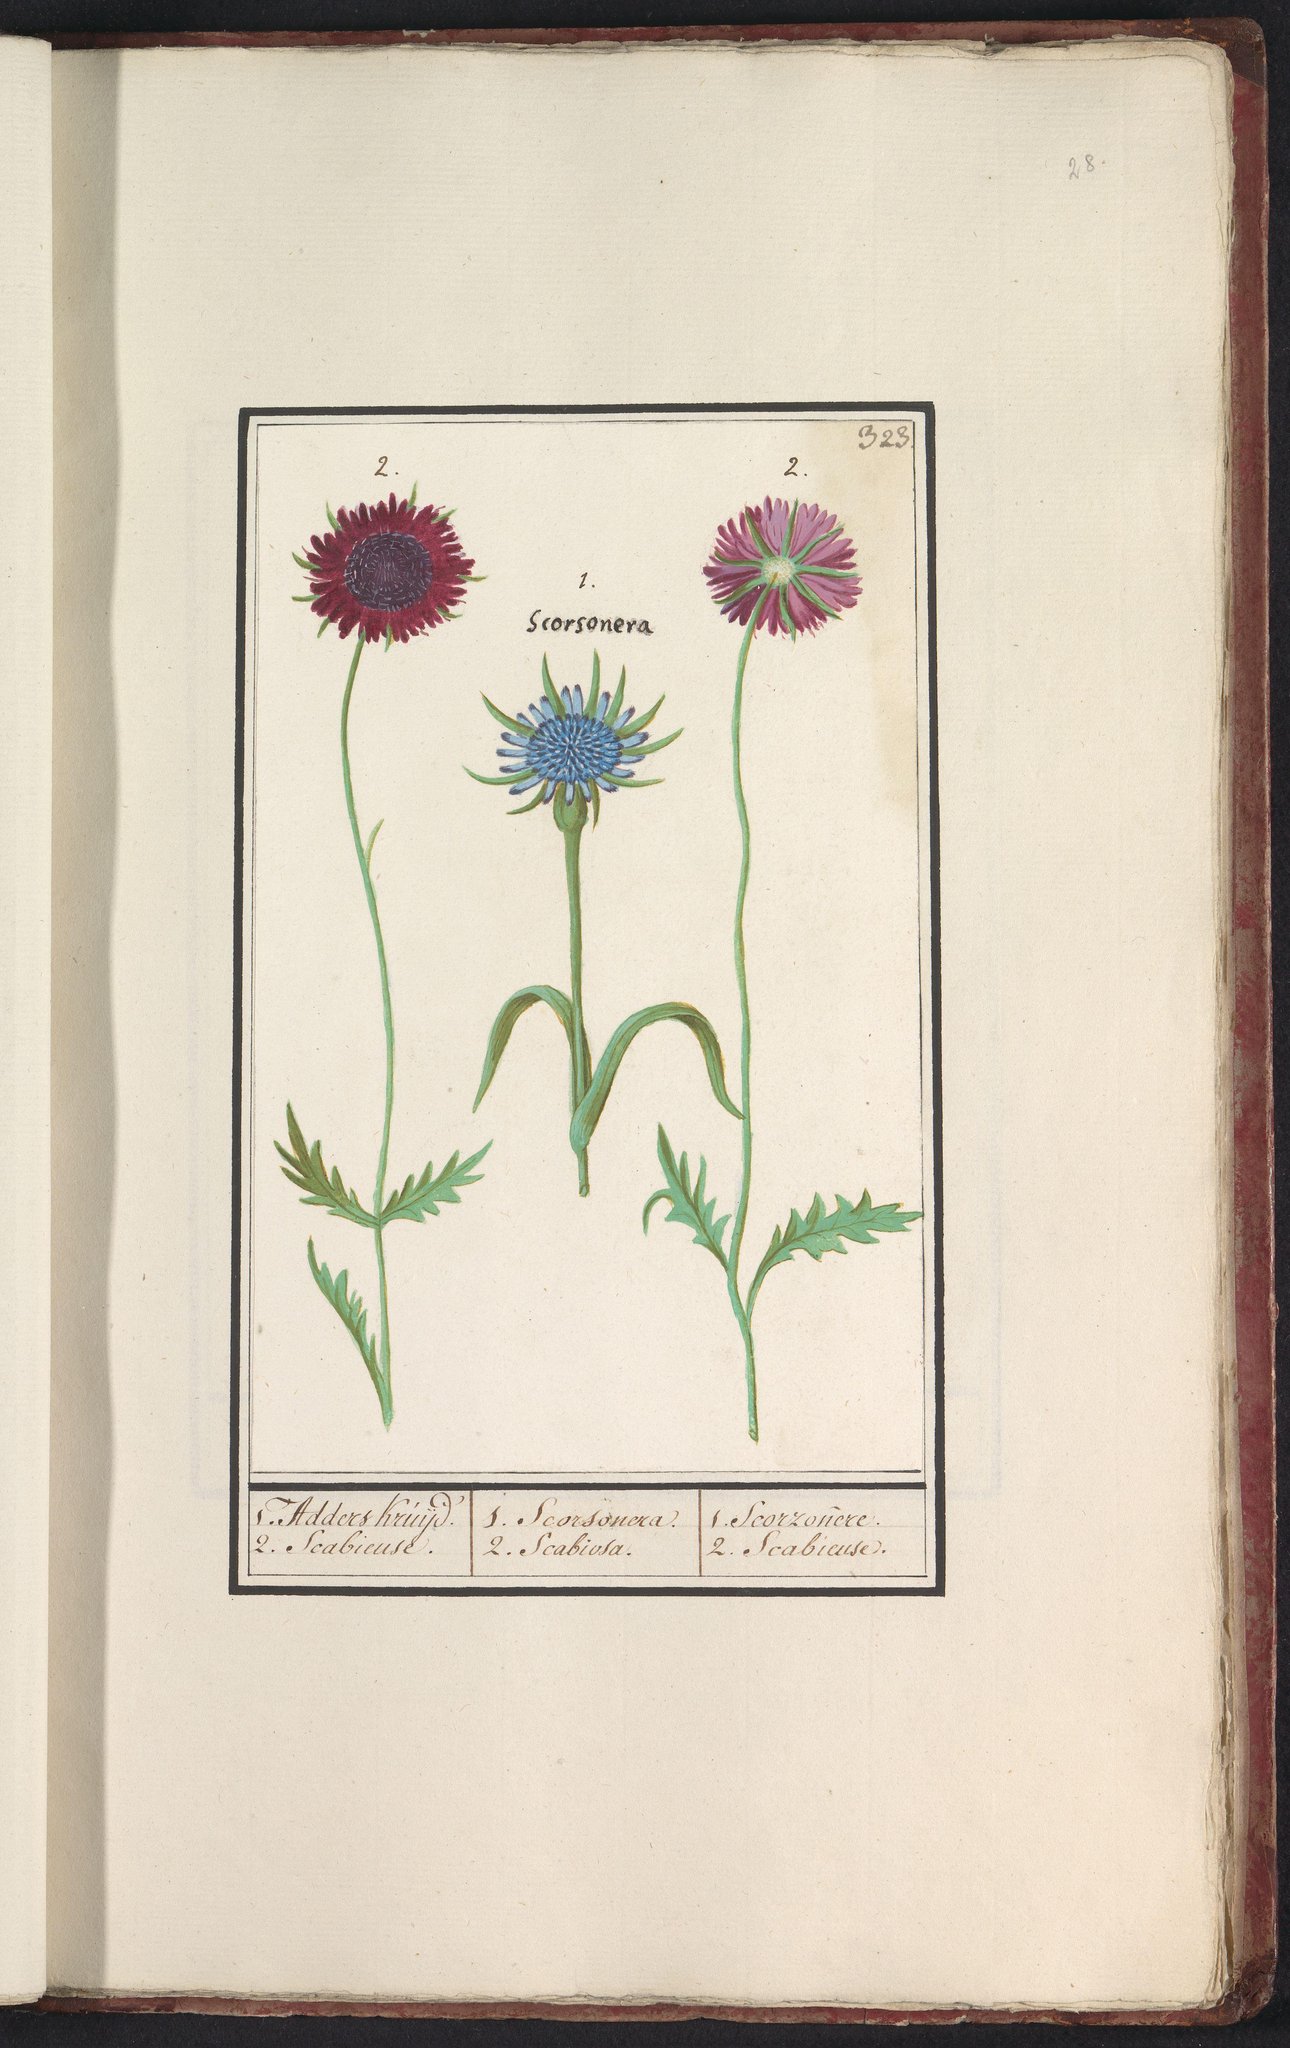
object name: drawing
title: Paarse morgenster (Tragopogon porrifolius) en scabiosa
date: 1596-1610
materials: chalk, paint, ink, paper, watercolor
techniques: brush, pen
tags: flowers: scabiosa, flowers: purple salsify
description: Paarse morgenster, ook wel boksbaard of witte schorseneer, en rode scabiosa. Genummerd rechtsboven: 323. Met de Latijnse naam. Onderdeel van het vierde album met tekeningen van bloemen en paddestoelen. Elfde van twaalf albums met tekeningen van dieren, vogels en planten bekend rond 1600, gemaakt in opdracht van keizer Rudolf II. Met toelichting in Nederlands, Latijn en Frans.